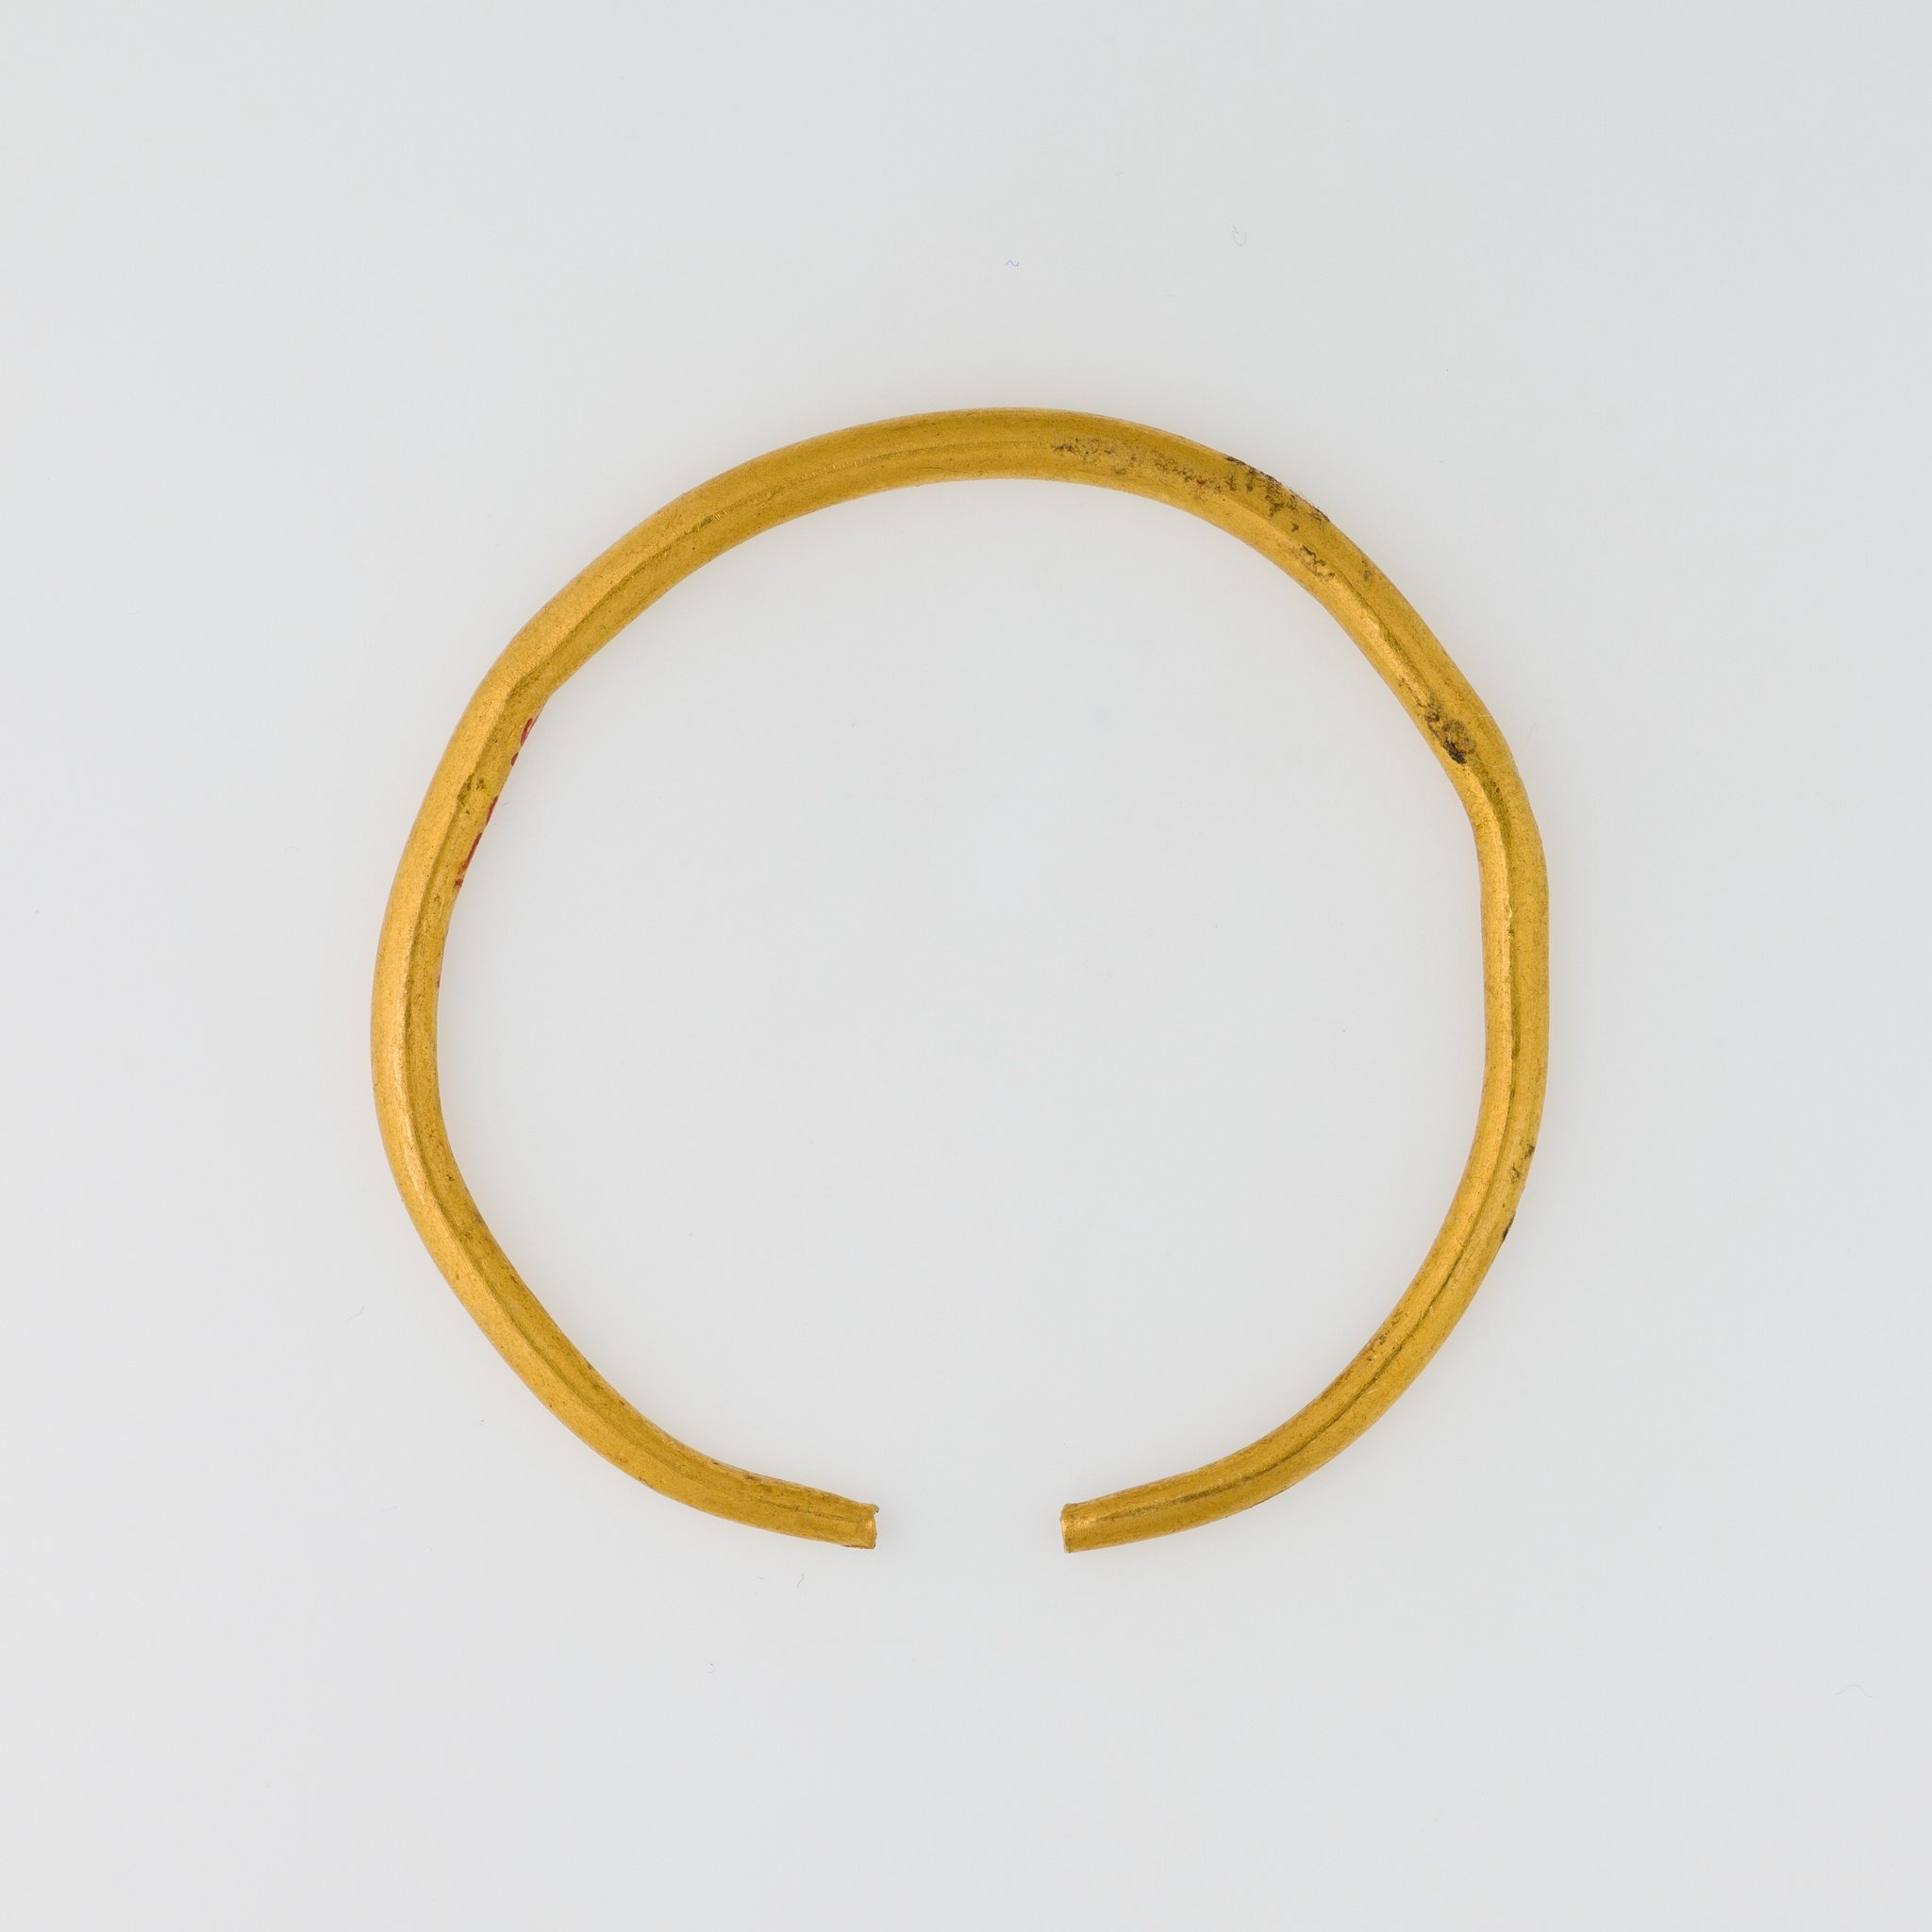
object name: earring, hoop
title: Hoop Earring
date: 1648-1540 BCE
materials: gold